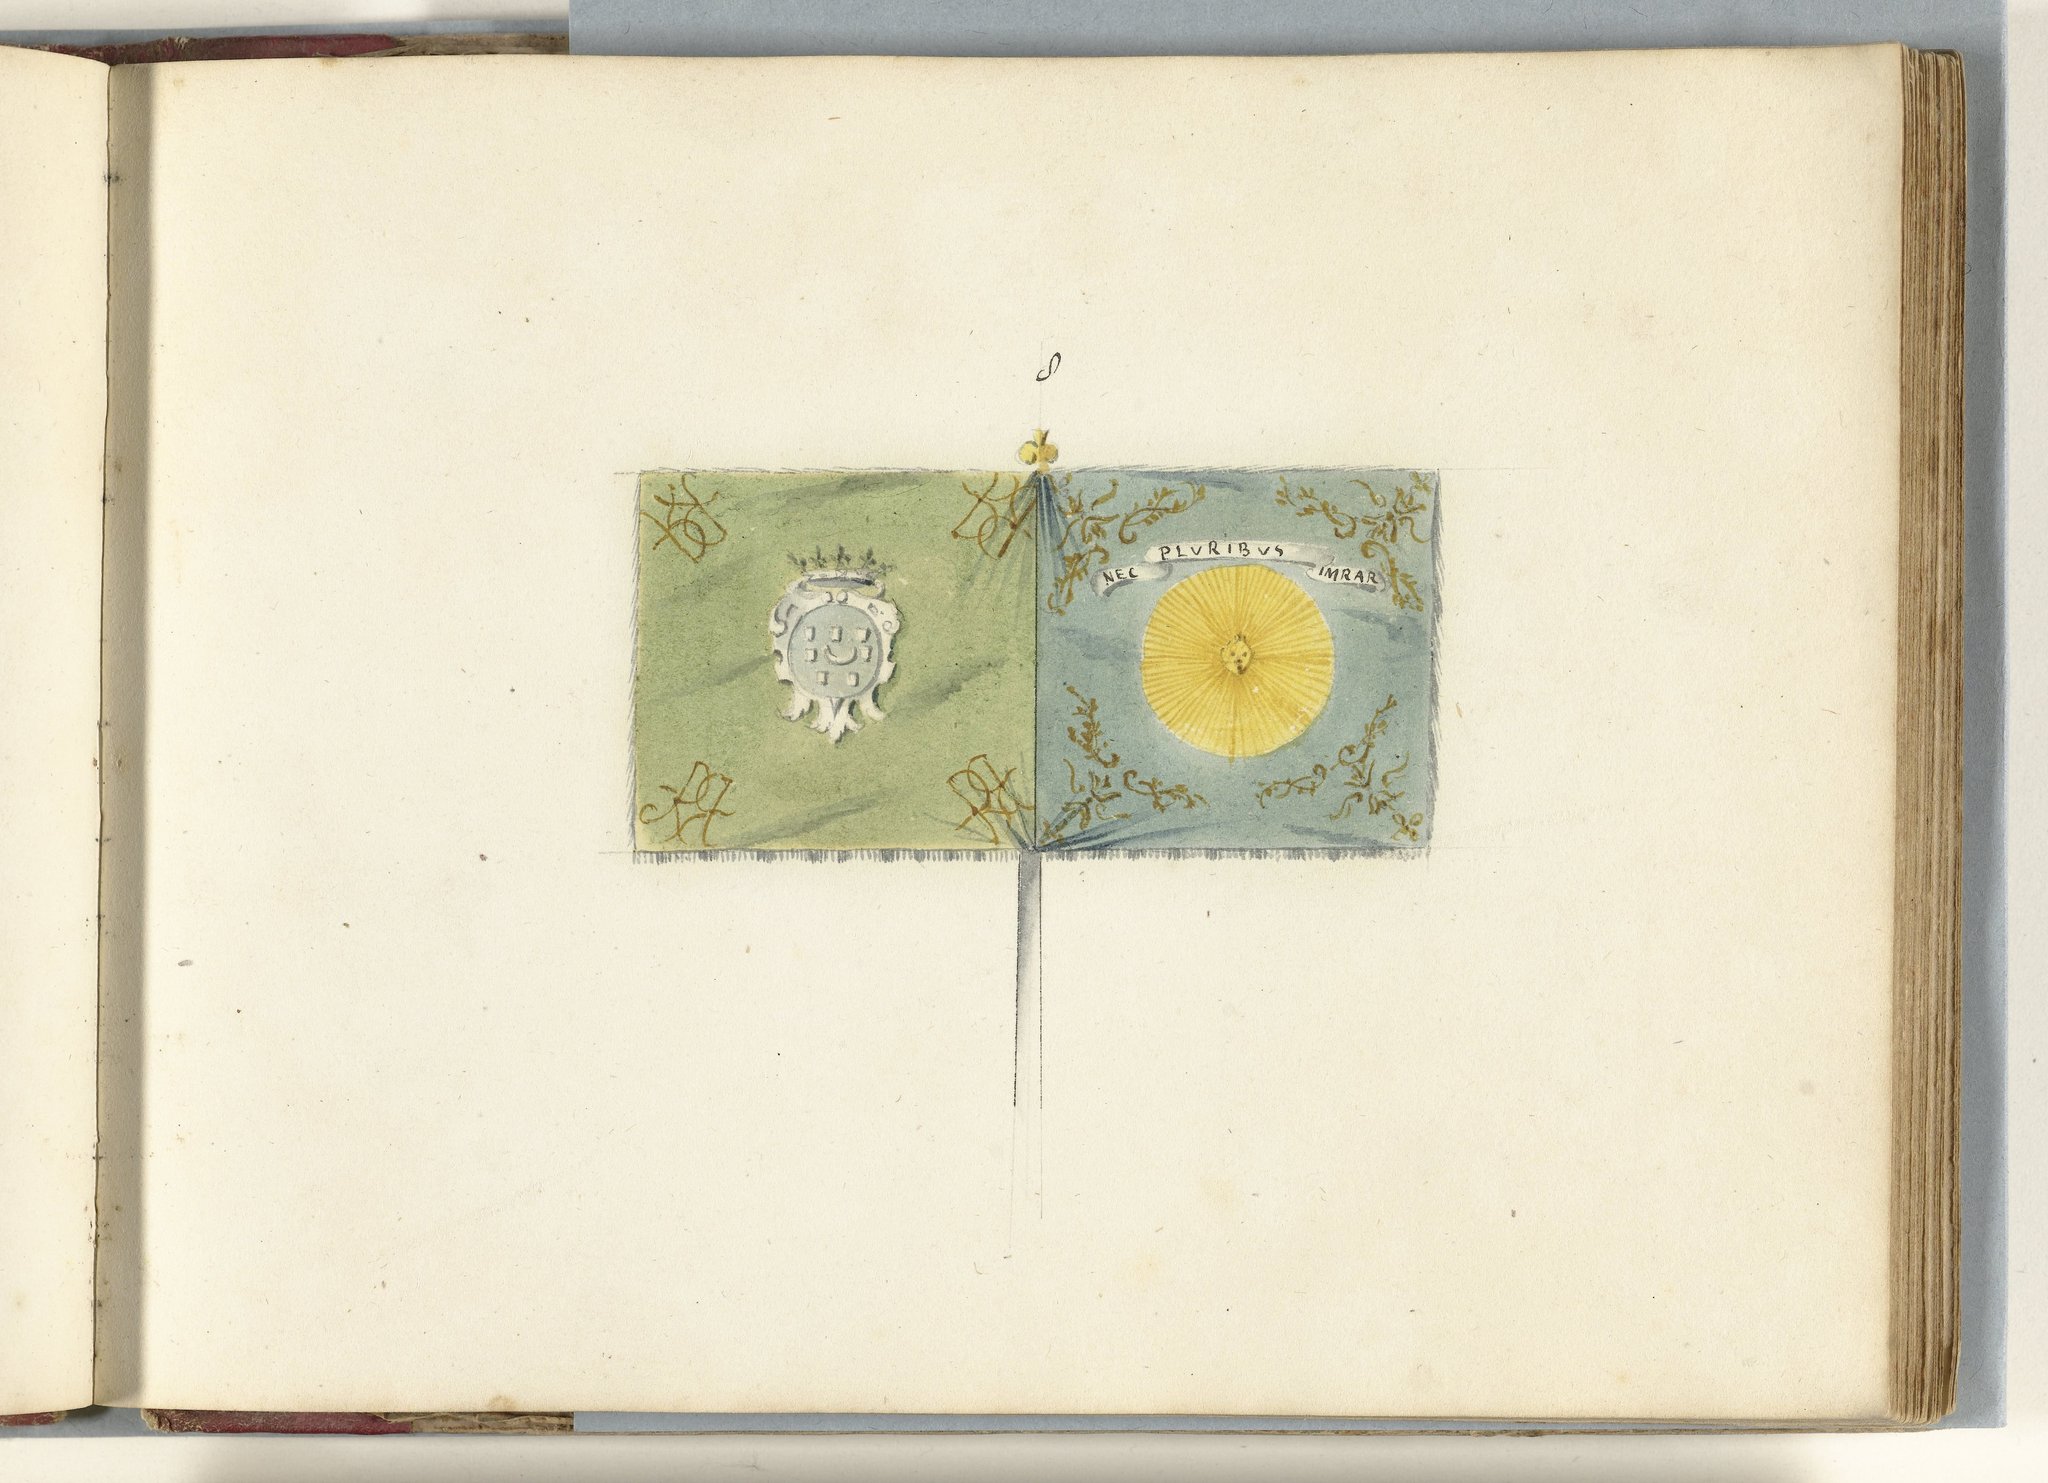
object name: drawing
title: Frans standaard, veroverd in de slag bij Oudenaarde, 1708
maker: Anonymous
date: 1713-1720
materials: paper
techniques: drawing, writing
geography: northern netherlands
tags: (military) flags and standards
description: Een Frans standaard, veroverd bij de slag bij Oudenaarde in 1708. In het boek met tekeningen van Franse vaandels, standaarden en pauken, veroverd tijdens de Spaanse Successieoorlog (1701-1713).